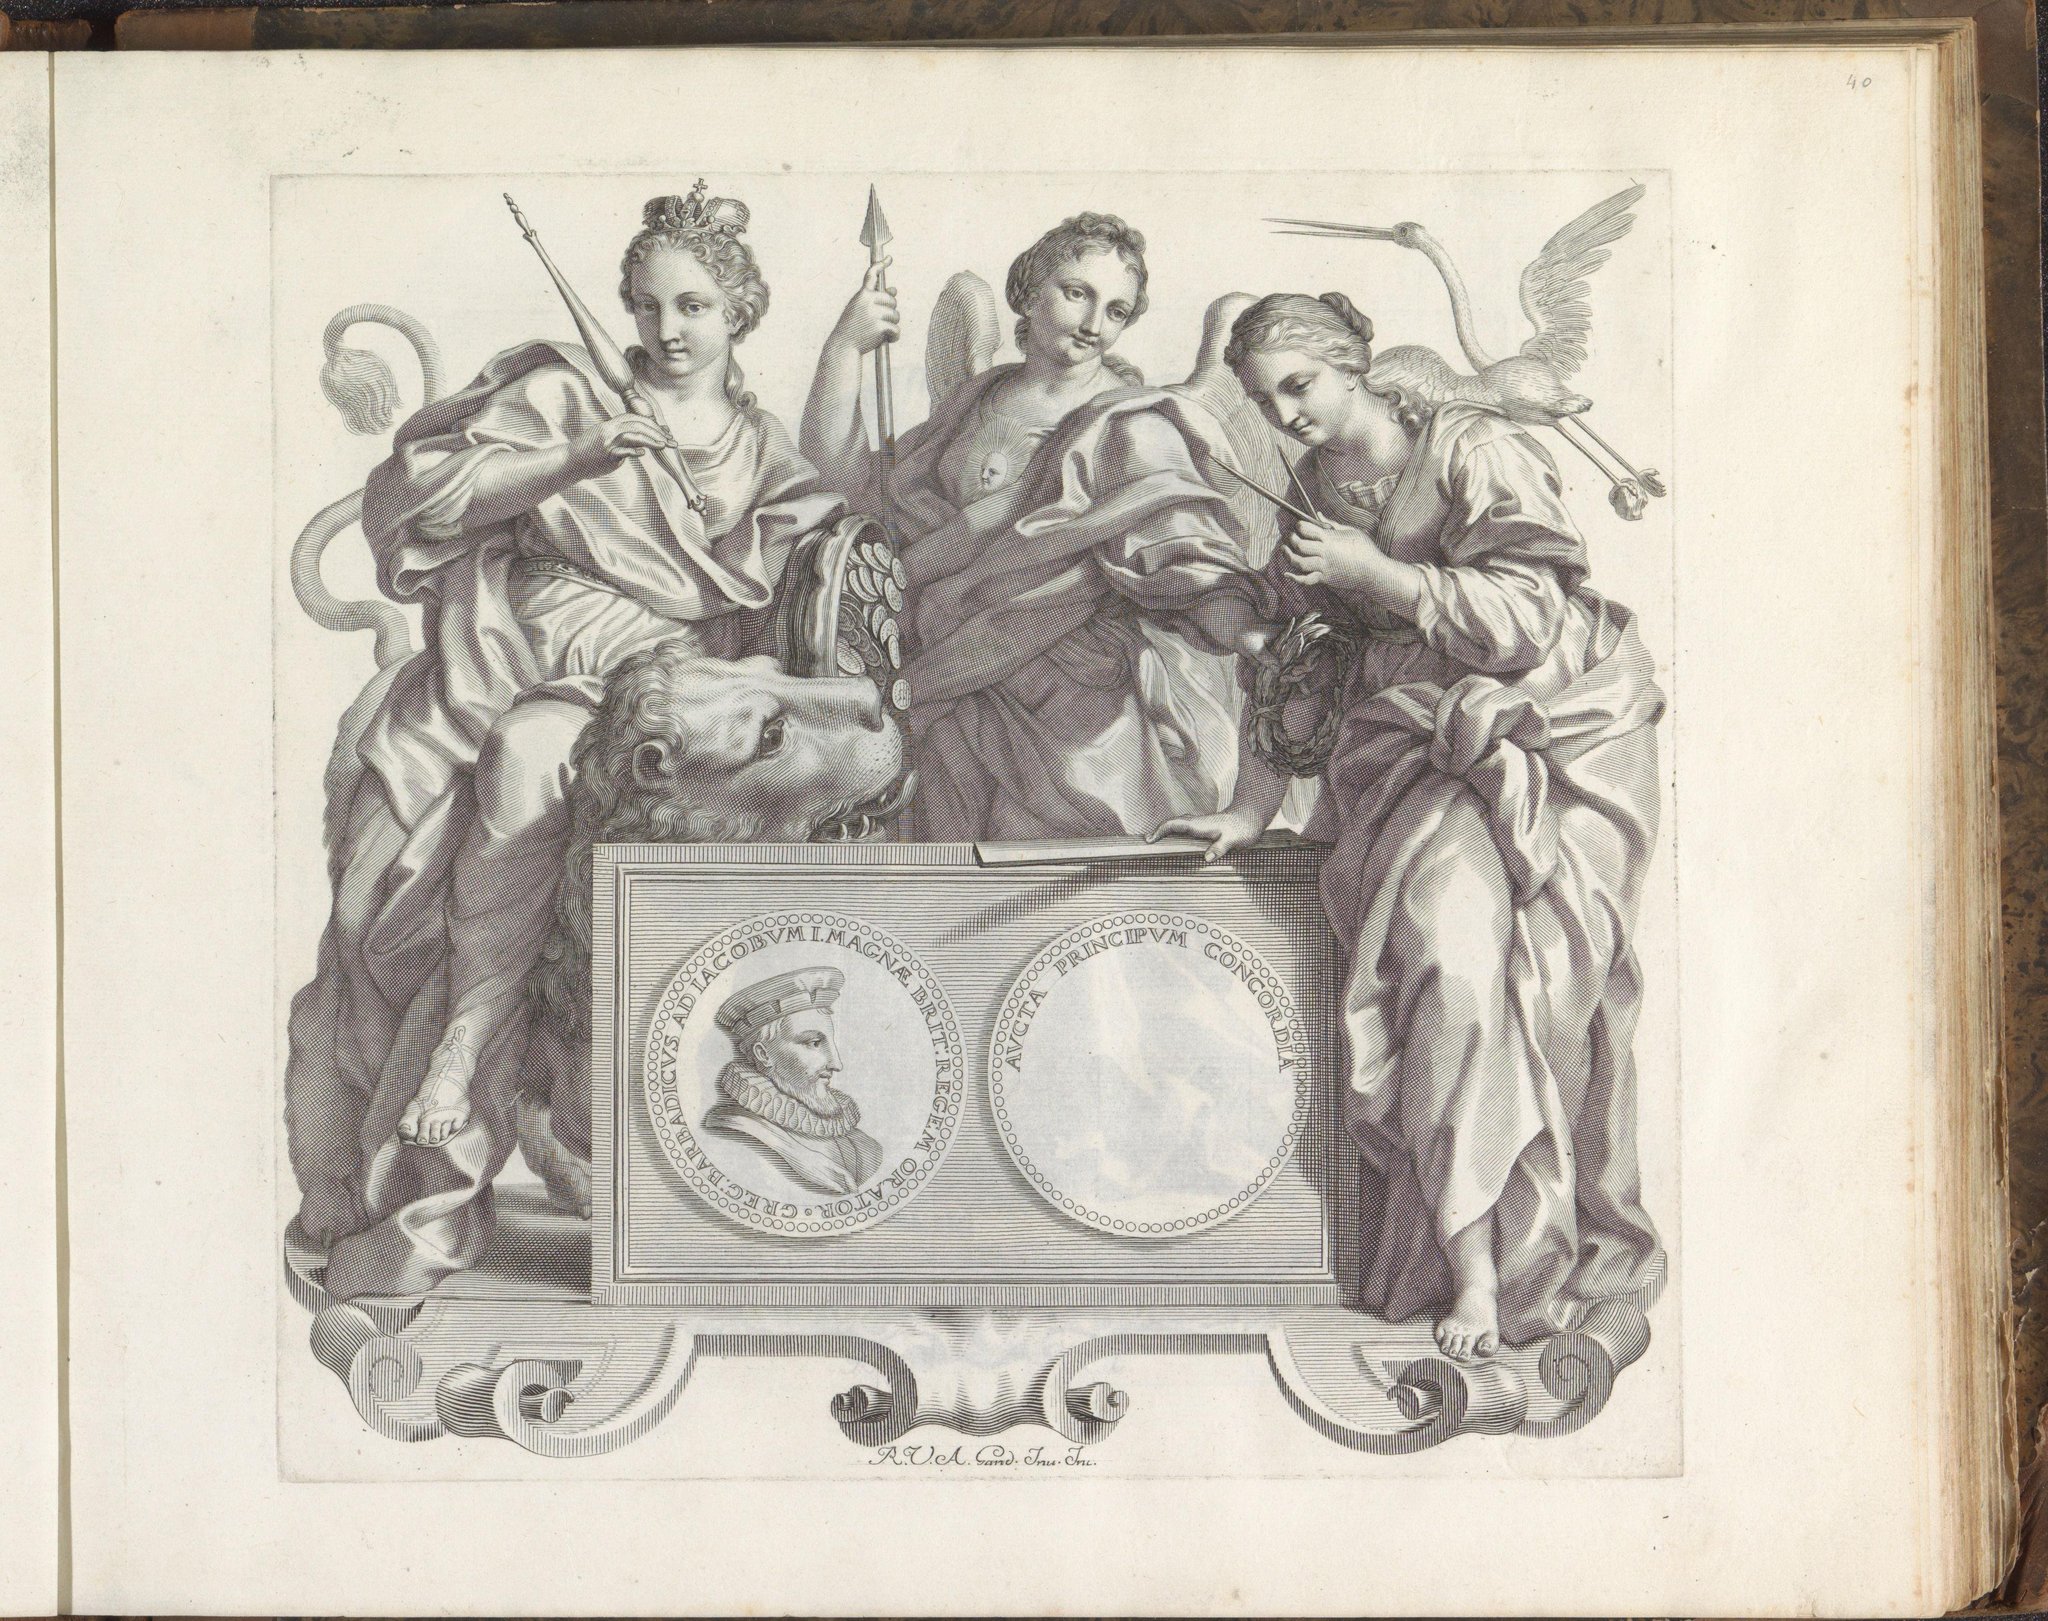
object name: print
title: Portret van Gregorio Barbarigo en de personificaties van Grootmoedigheid, Deugd en Consideratie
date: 1673-1743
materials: paper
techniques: engraving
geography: rome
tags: shore-birds and wading-birds: crane, garland, wreath, consideration; 'consideratione' (ripa), compasses, medal (considered as a piece of sculpture, regardless of its specific function), beasts of prey, predatory animals: lion, magnanimity; 'grandezza e robustezza d'animo', 'magnanimità' (ripa)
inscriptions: collector's mark: Lugt 2228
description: Voetstuk in de vorm van een cartouche. Daarop een medaillon met op de voorzijde het portret van Gregorio Barbarigo, ambassadeur in Engeland ten tijde van Jacobus I. Op de achterzijde alleen de spreuk: Aucta Principum Concordia. Rond het voetstuk drie personificaties. Links de personificatie van Grootmoedigheid: een vrouw zittende op een leeuw, met kroon en scepter en een hoorn des overvloeds gevuld met penningen. In het midden de Deugd: een gevleugelde vrouw met in haar linkerhand een spies en in haar rechterhand een lauwerkrans. Op haar borst de zon. Rechts staat Consideratie. Het betreft een vrouw met passer en liniaal. Haar attribuut is de vliegende kraanvogel met een steen in haar poot. De prent maakt deel uit van een album.